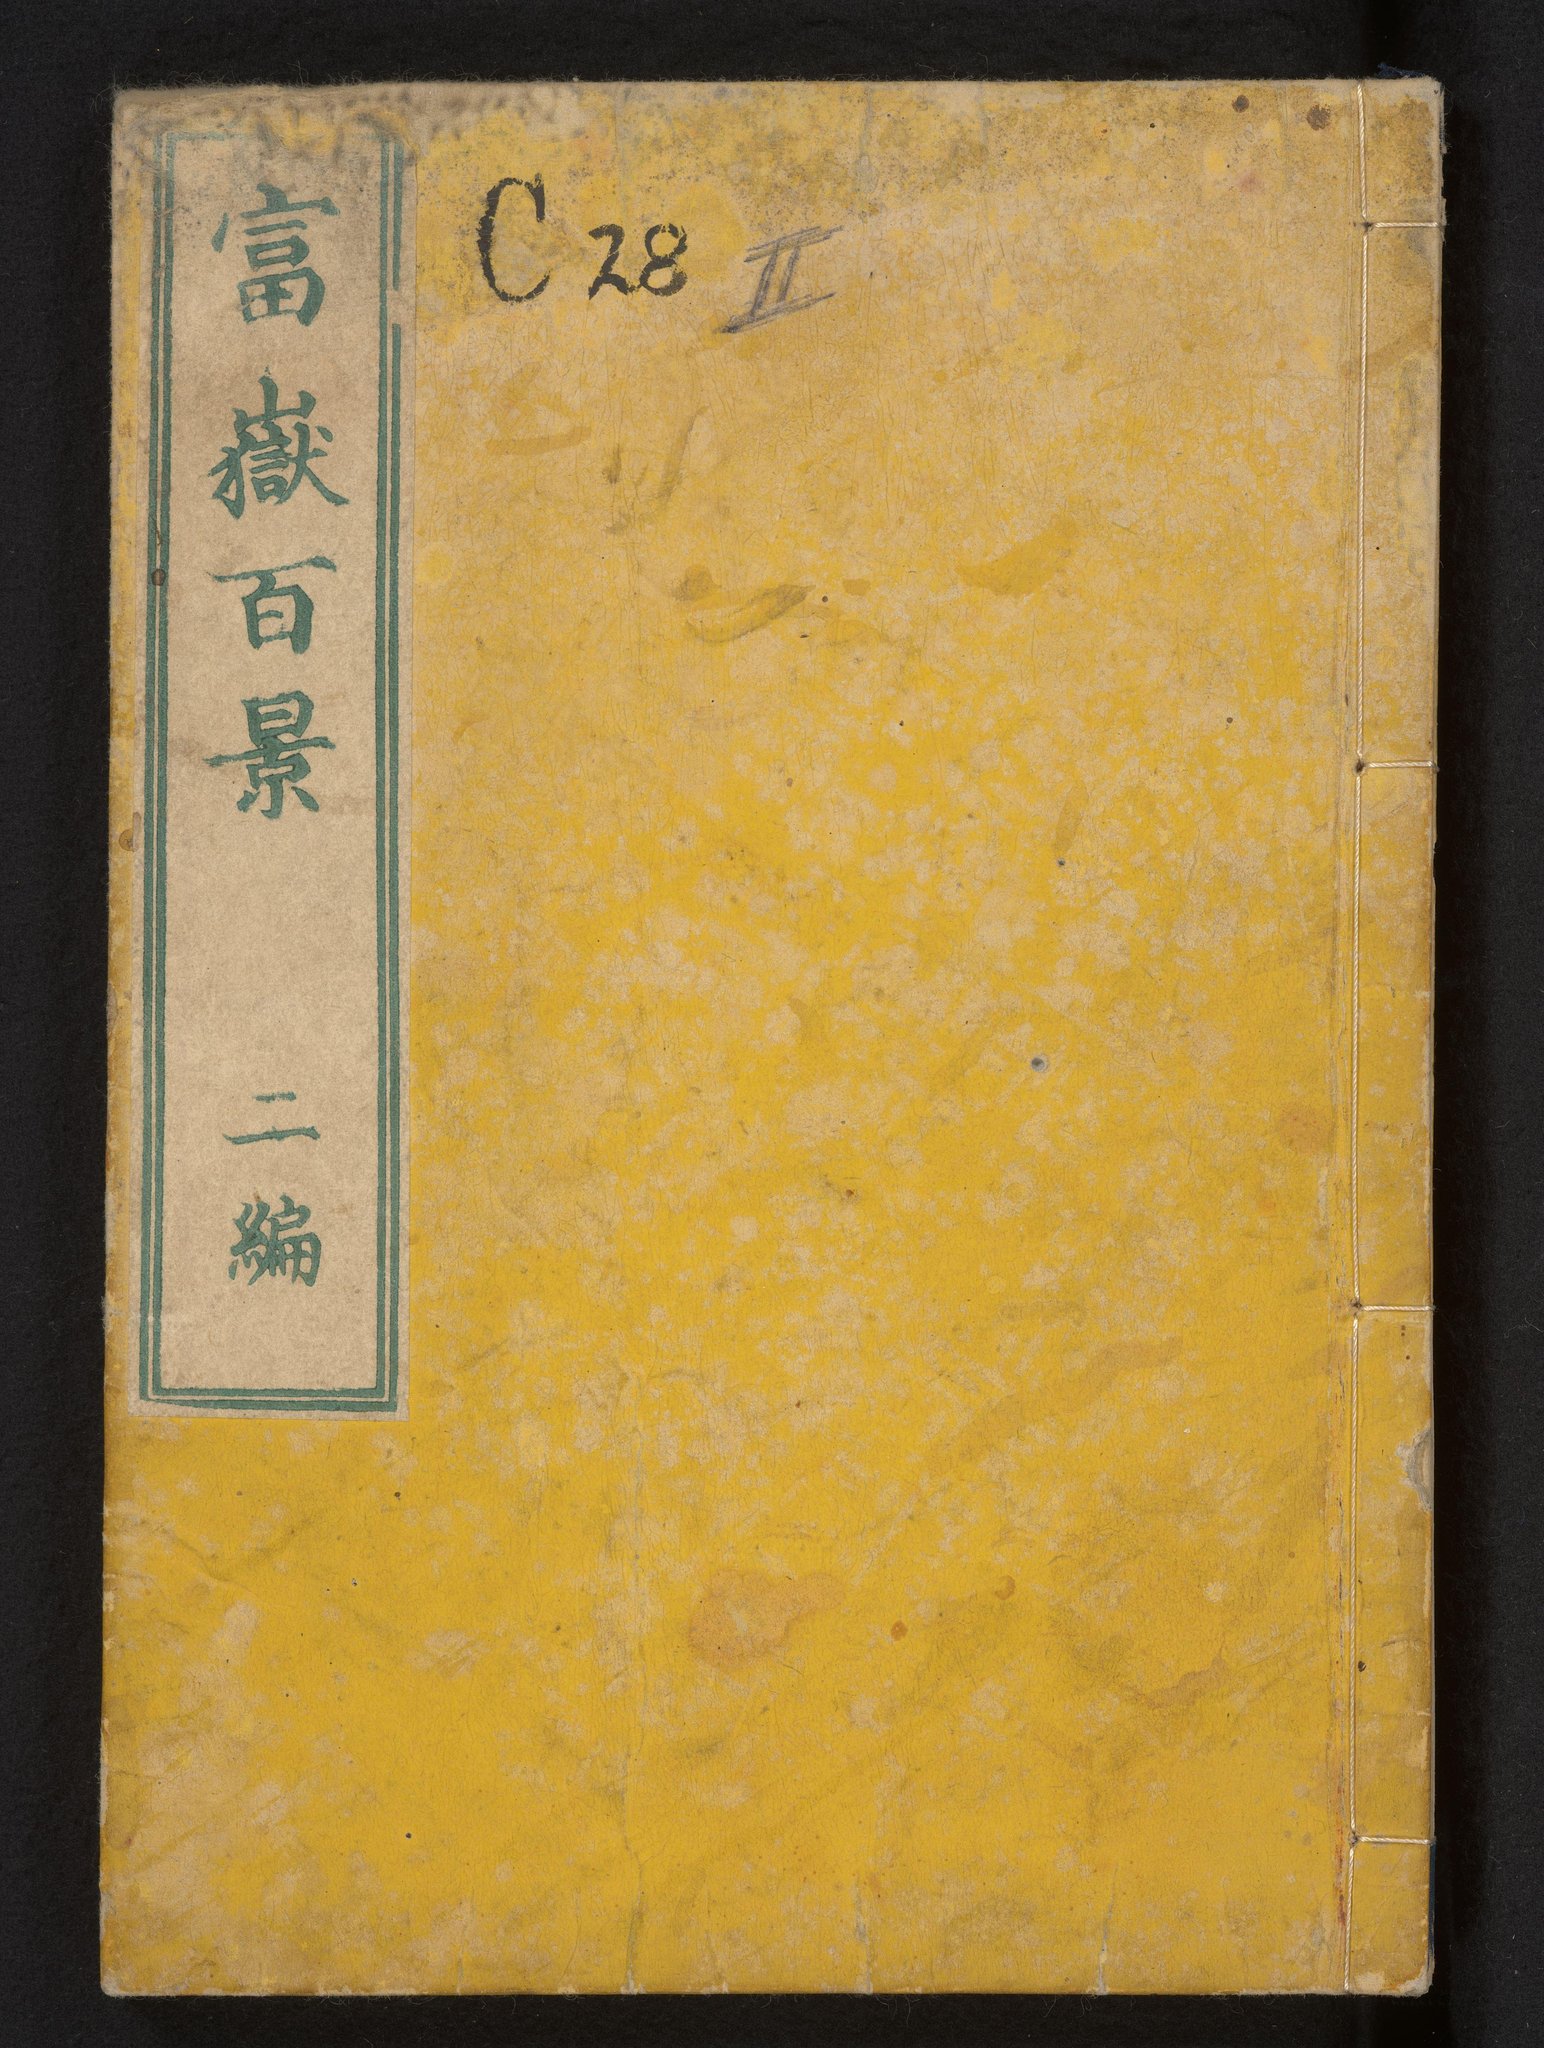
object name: book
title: Honderd gezichten op de berg Fuji - deel twee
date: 1835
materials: paper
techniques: woodcut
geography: nagoya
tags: fuji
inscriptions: collector's mark: Lugt 2228